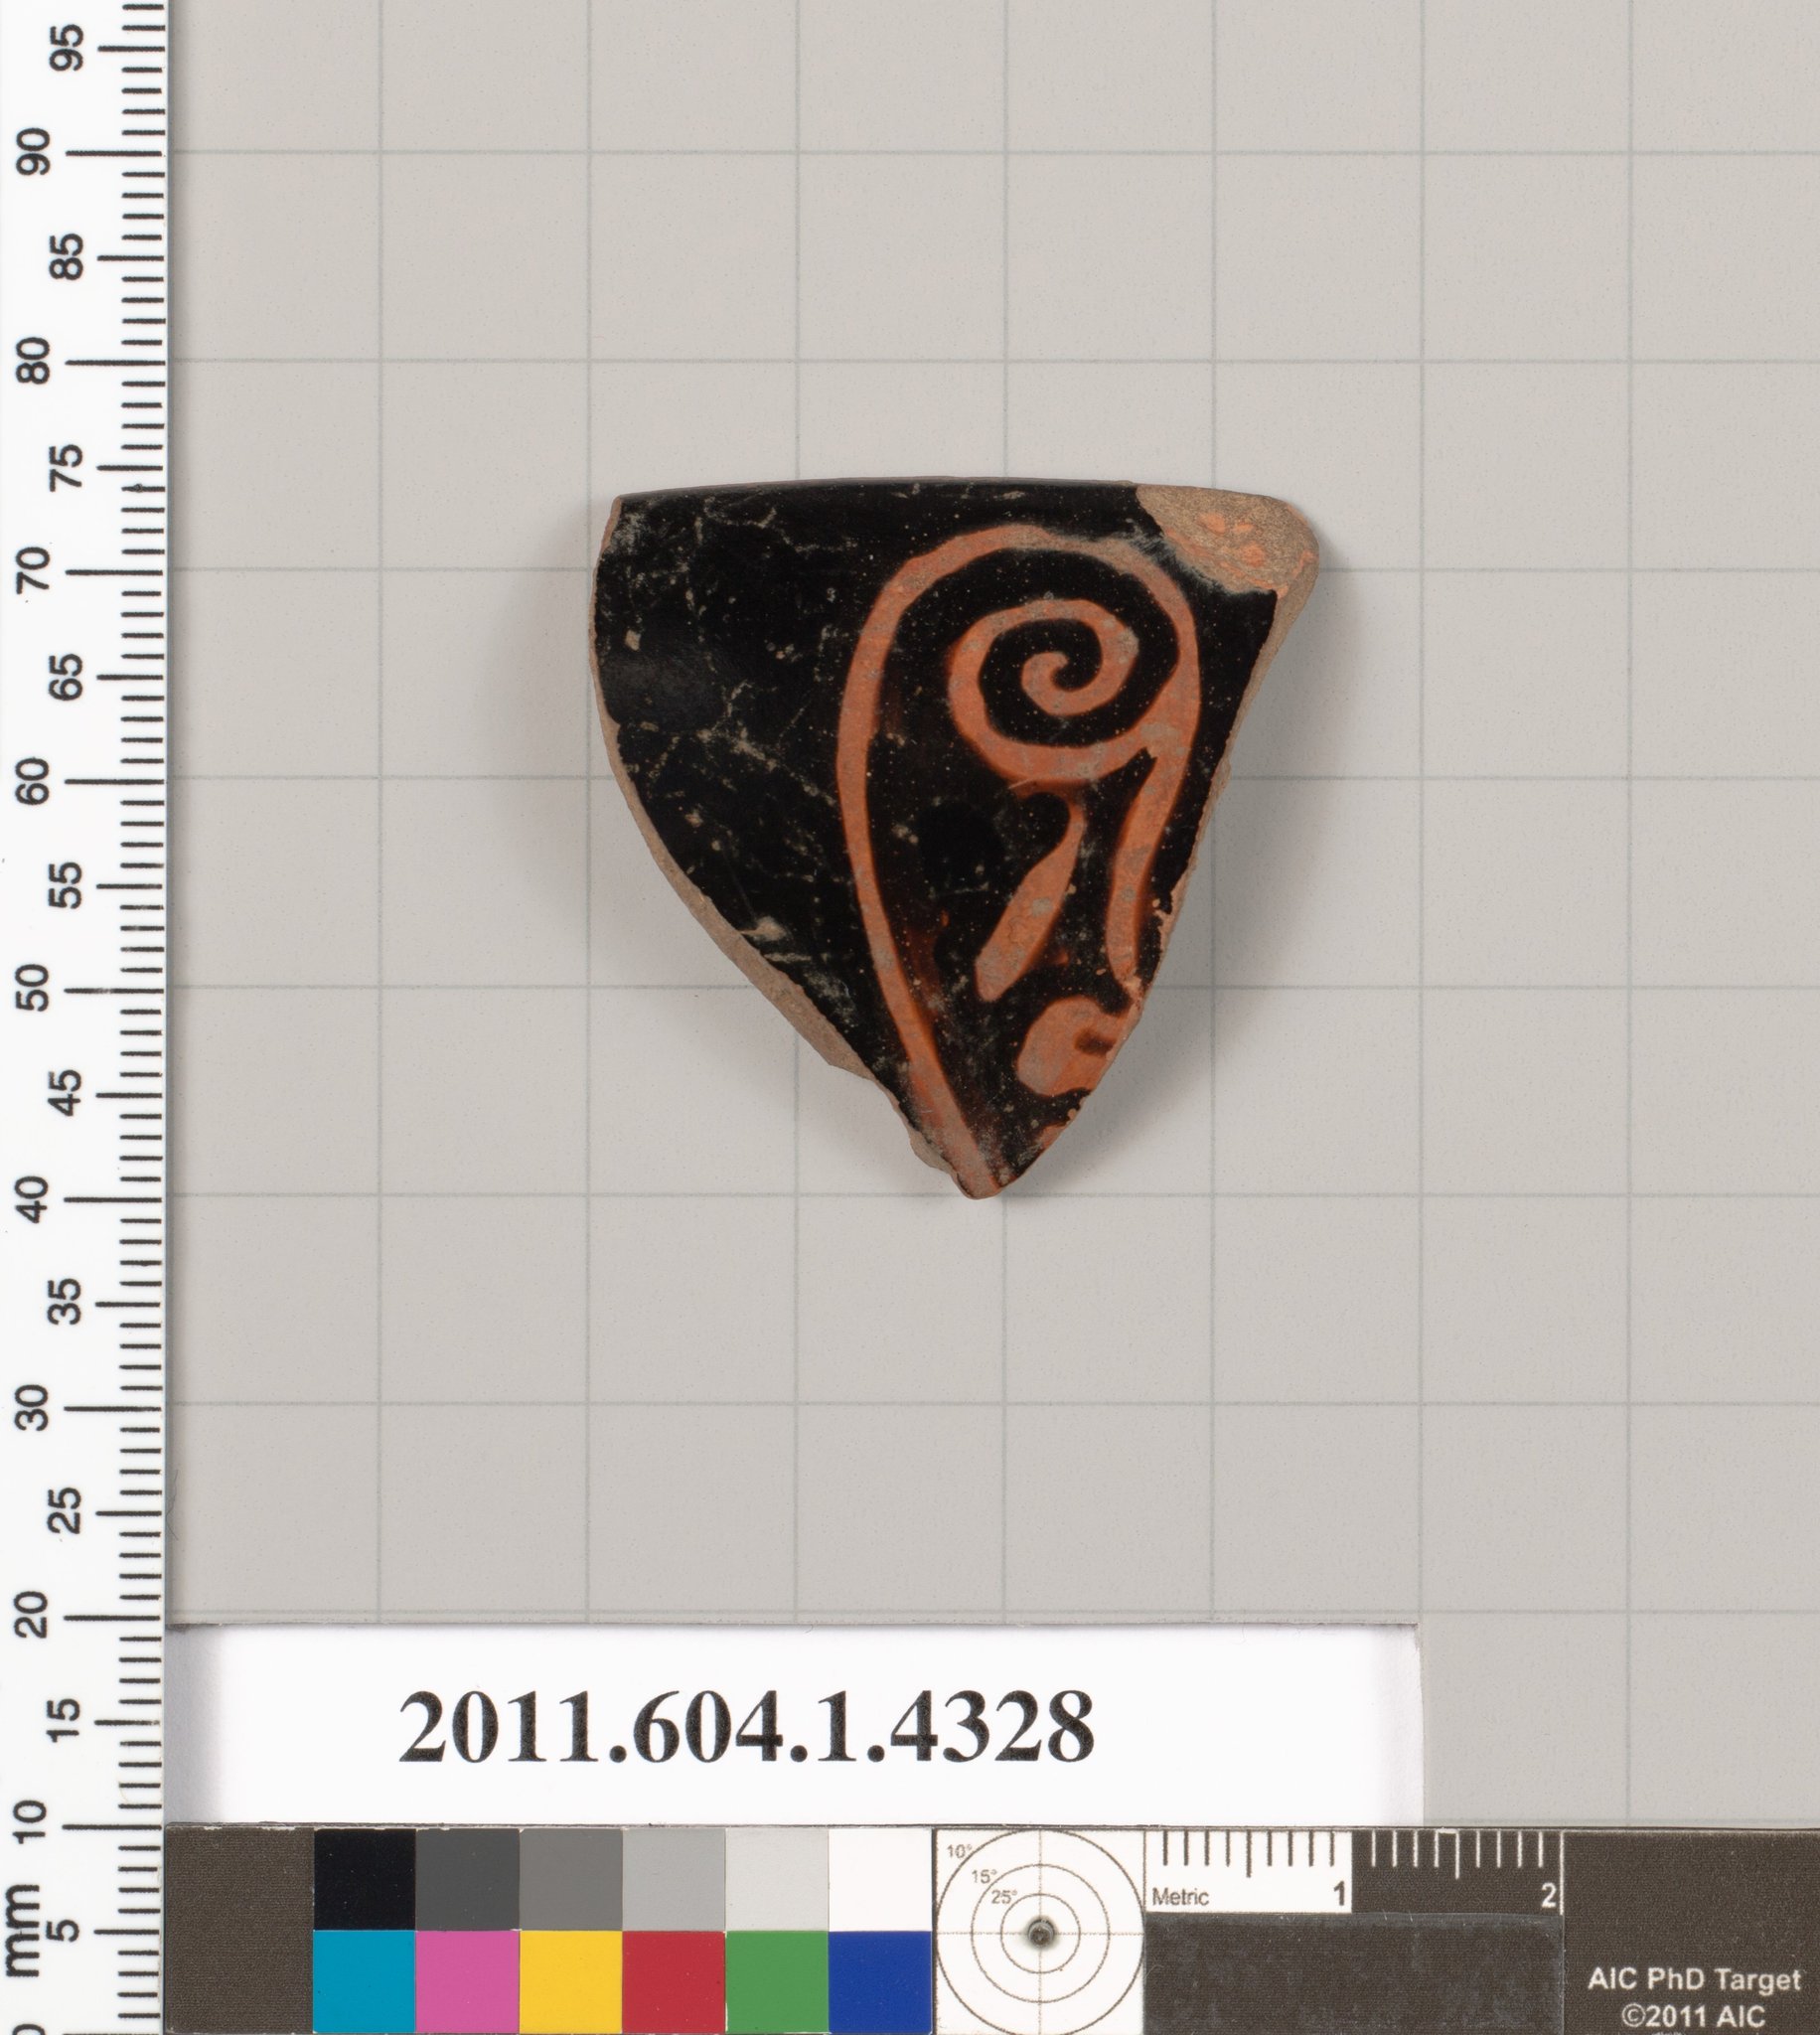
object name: kylix fragment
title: Terracotta fragment of a kylix (drinking cup)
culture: greek, attic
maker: splanchnopt painter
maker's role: artist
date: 470-450 BCE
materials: terracotta